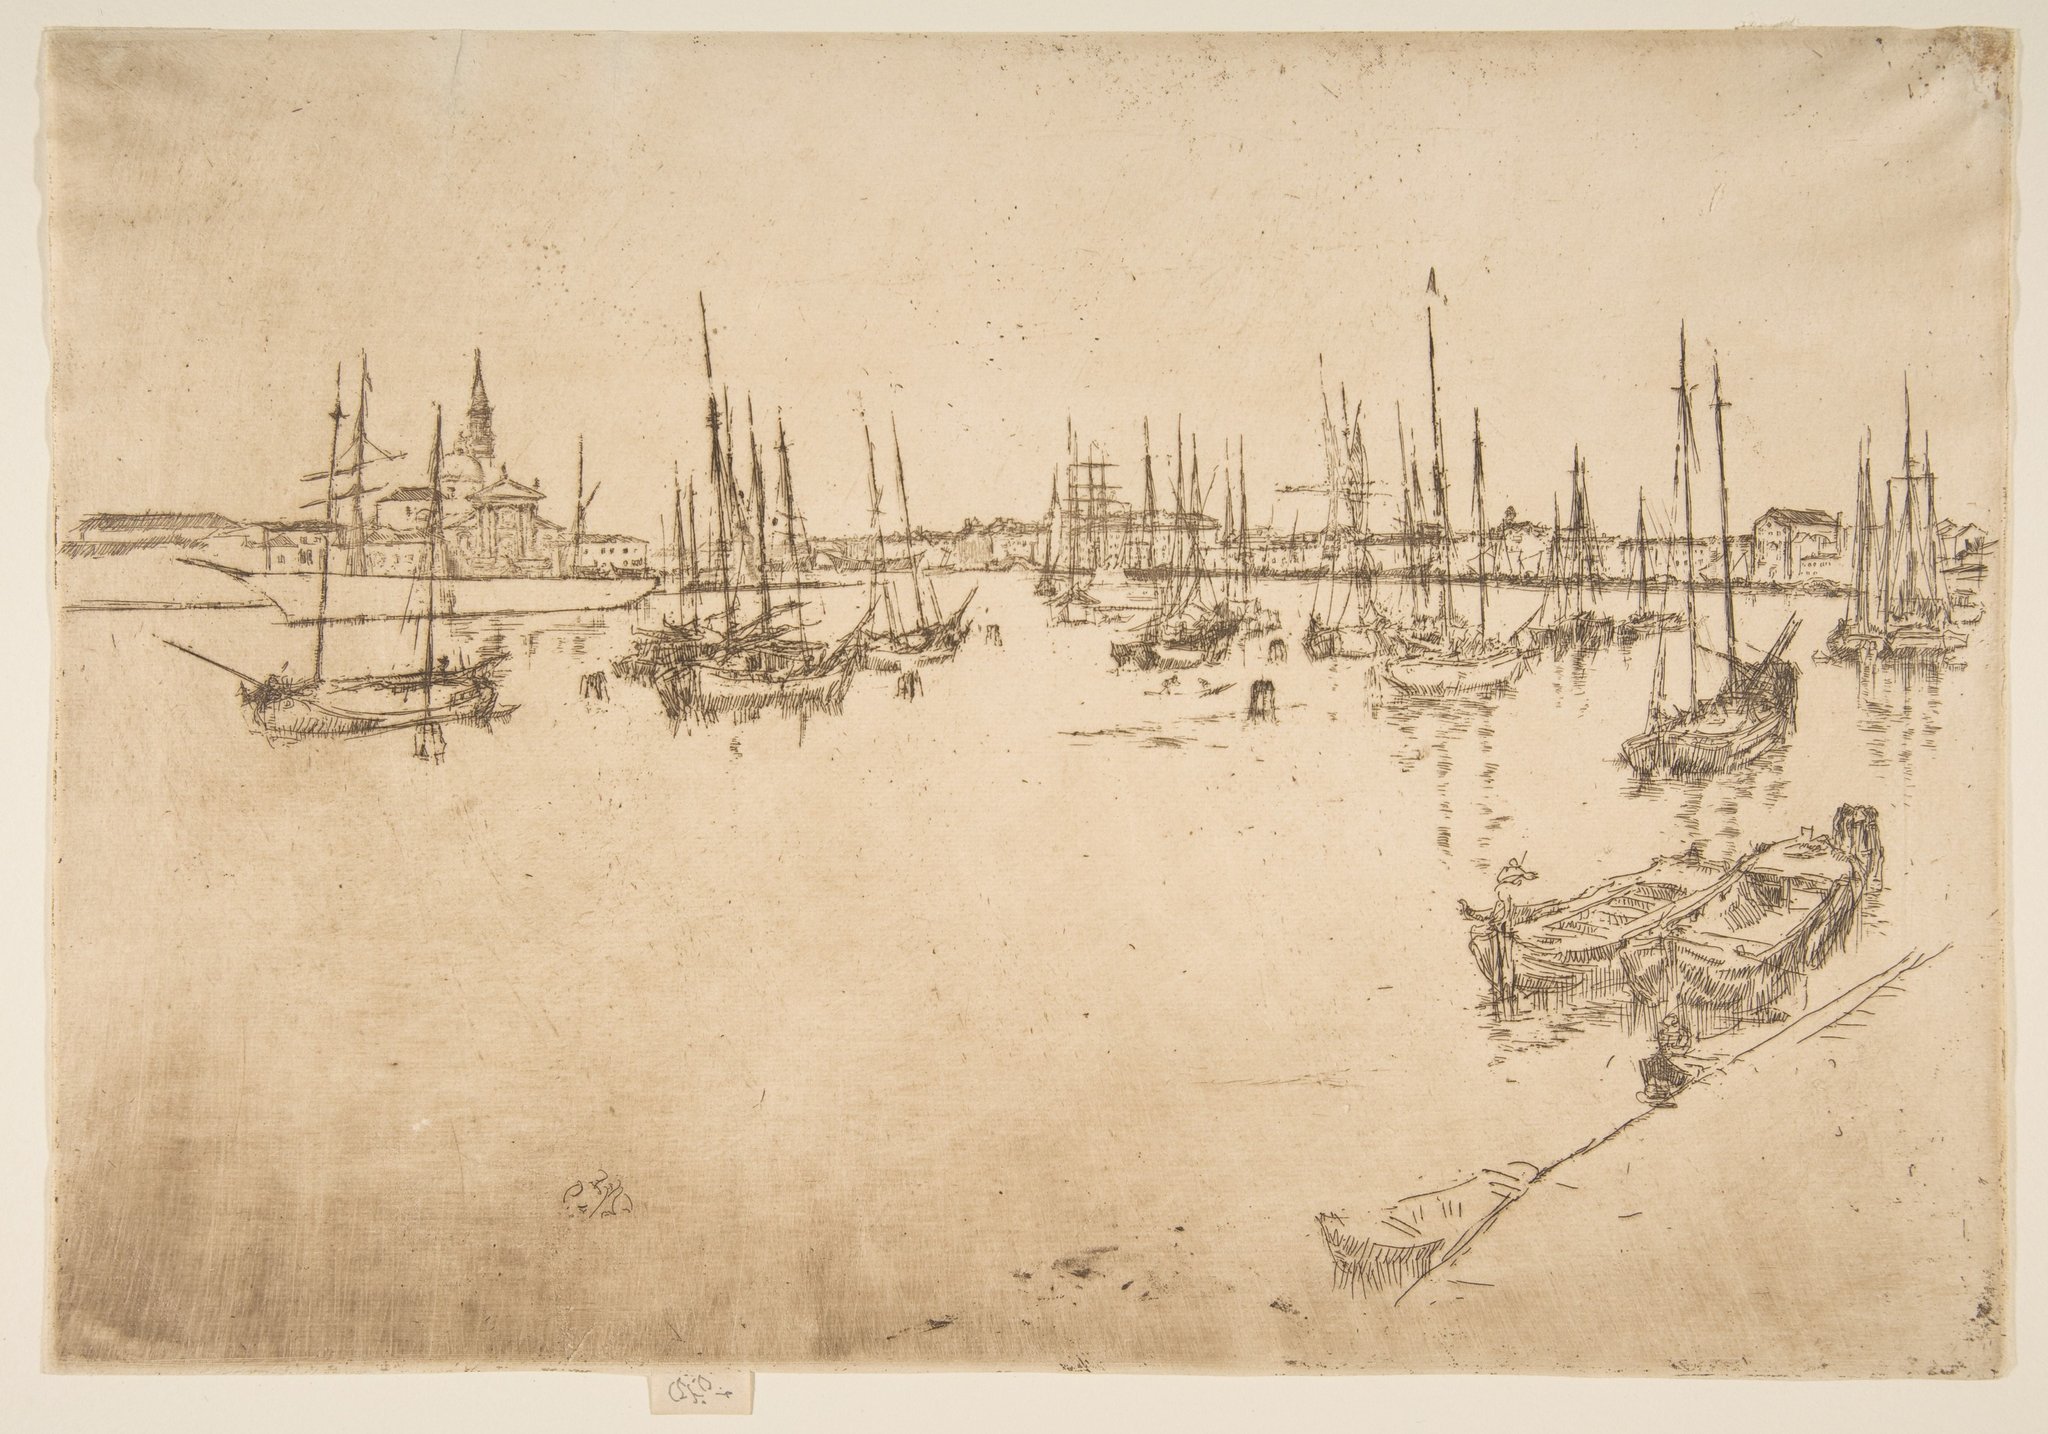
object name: print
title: San Giorgio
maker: james mcneill whistler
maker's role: artist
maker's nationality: american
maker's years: 1834-1903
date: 1879-1880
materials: ink, paper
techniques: drypoint, etching, printing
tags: boats,venice